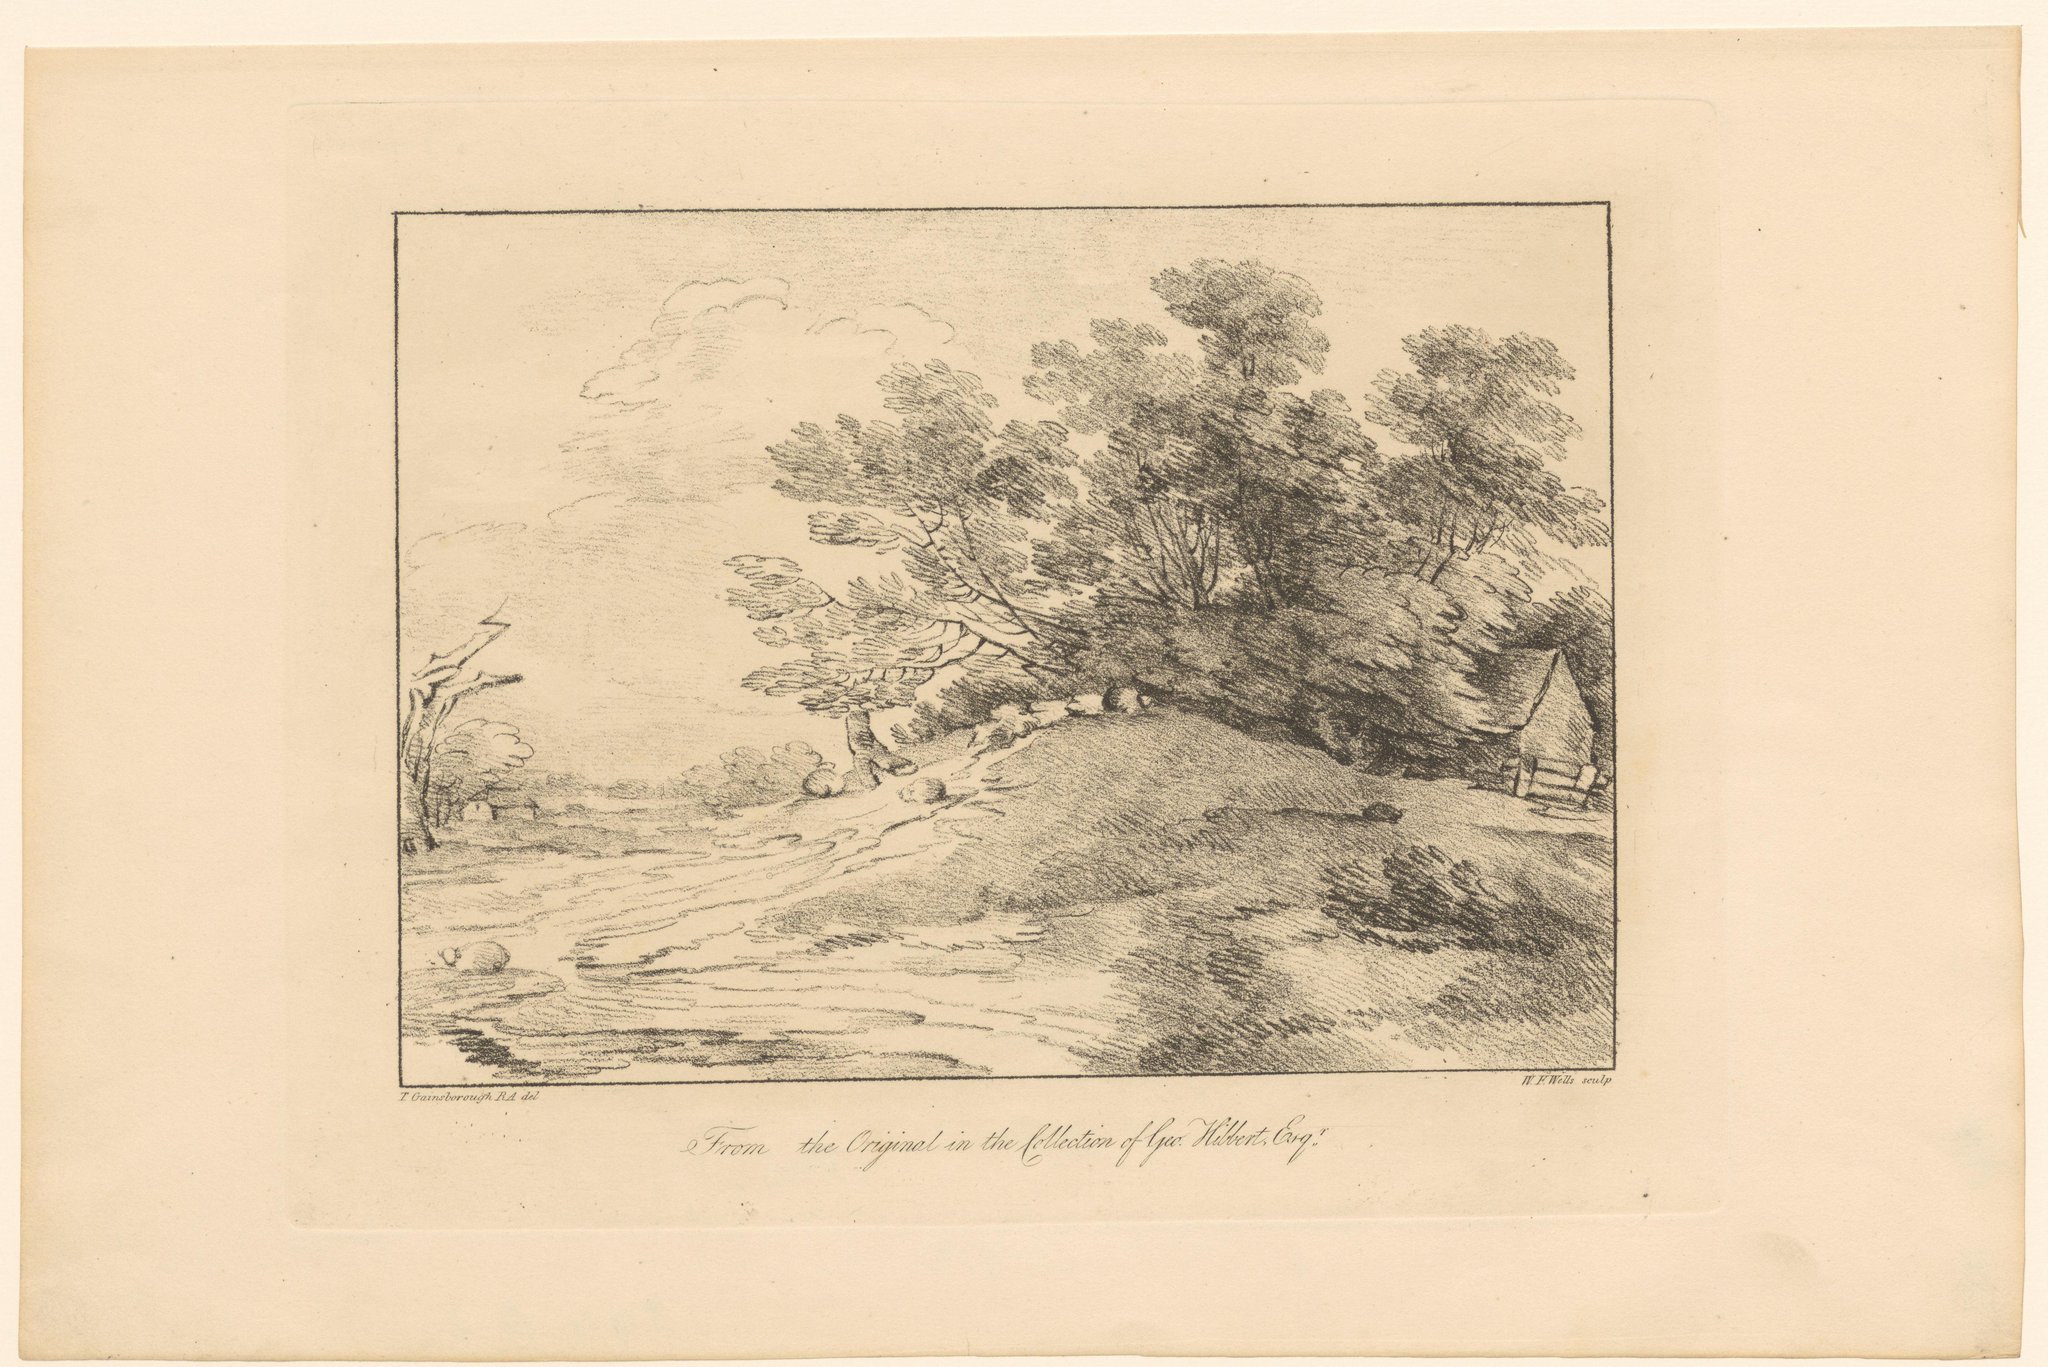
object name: print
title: Boomgroep en hut op lage heuvel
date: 1819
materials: paper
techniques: soft ground etching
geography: london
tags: low hill country, trees, cottage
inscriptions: collector's mark: Lugt 2228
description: Tussen ca. 1802 en ca. 1805 gaf Wells samen met John Laporte verschillende prenten uit naar tekeningen van Gainsborough. Deze werden in 1819 gebundeld uitgegeven door H.R. Young onder de titel A Collection Of Prints Illustrative Of English Scenery (...). Dit gebundelde werk is door Laporte en Wells opgedragen aan George Hibbert, die een collectie tekeningen van Thomas Gainsborough in zijn bezit had.